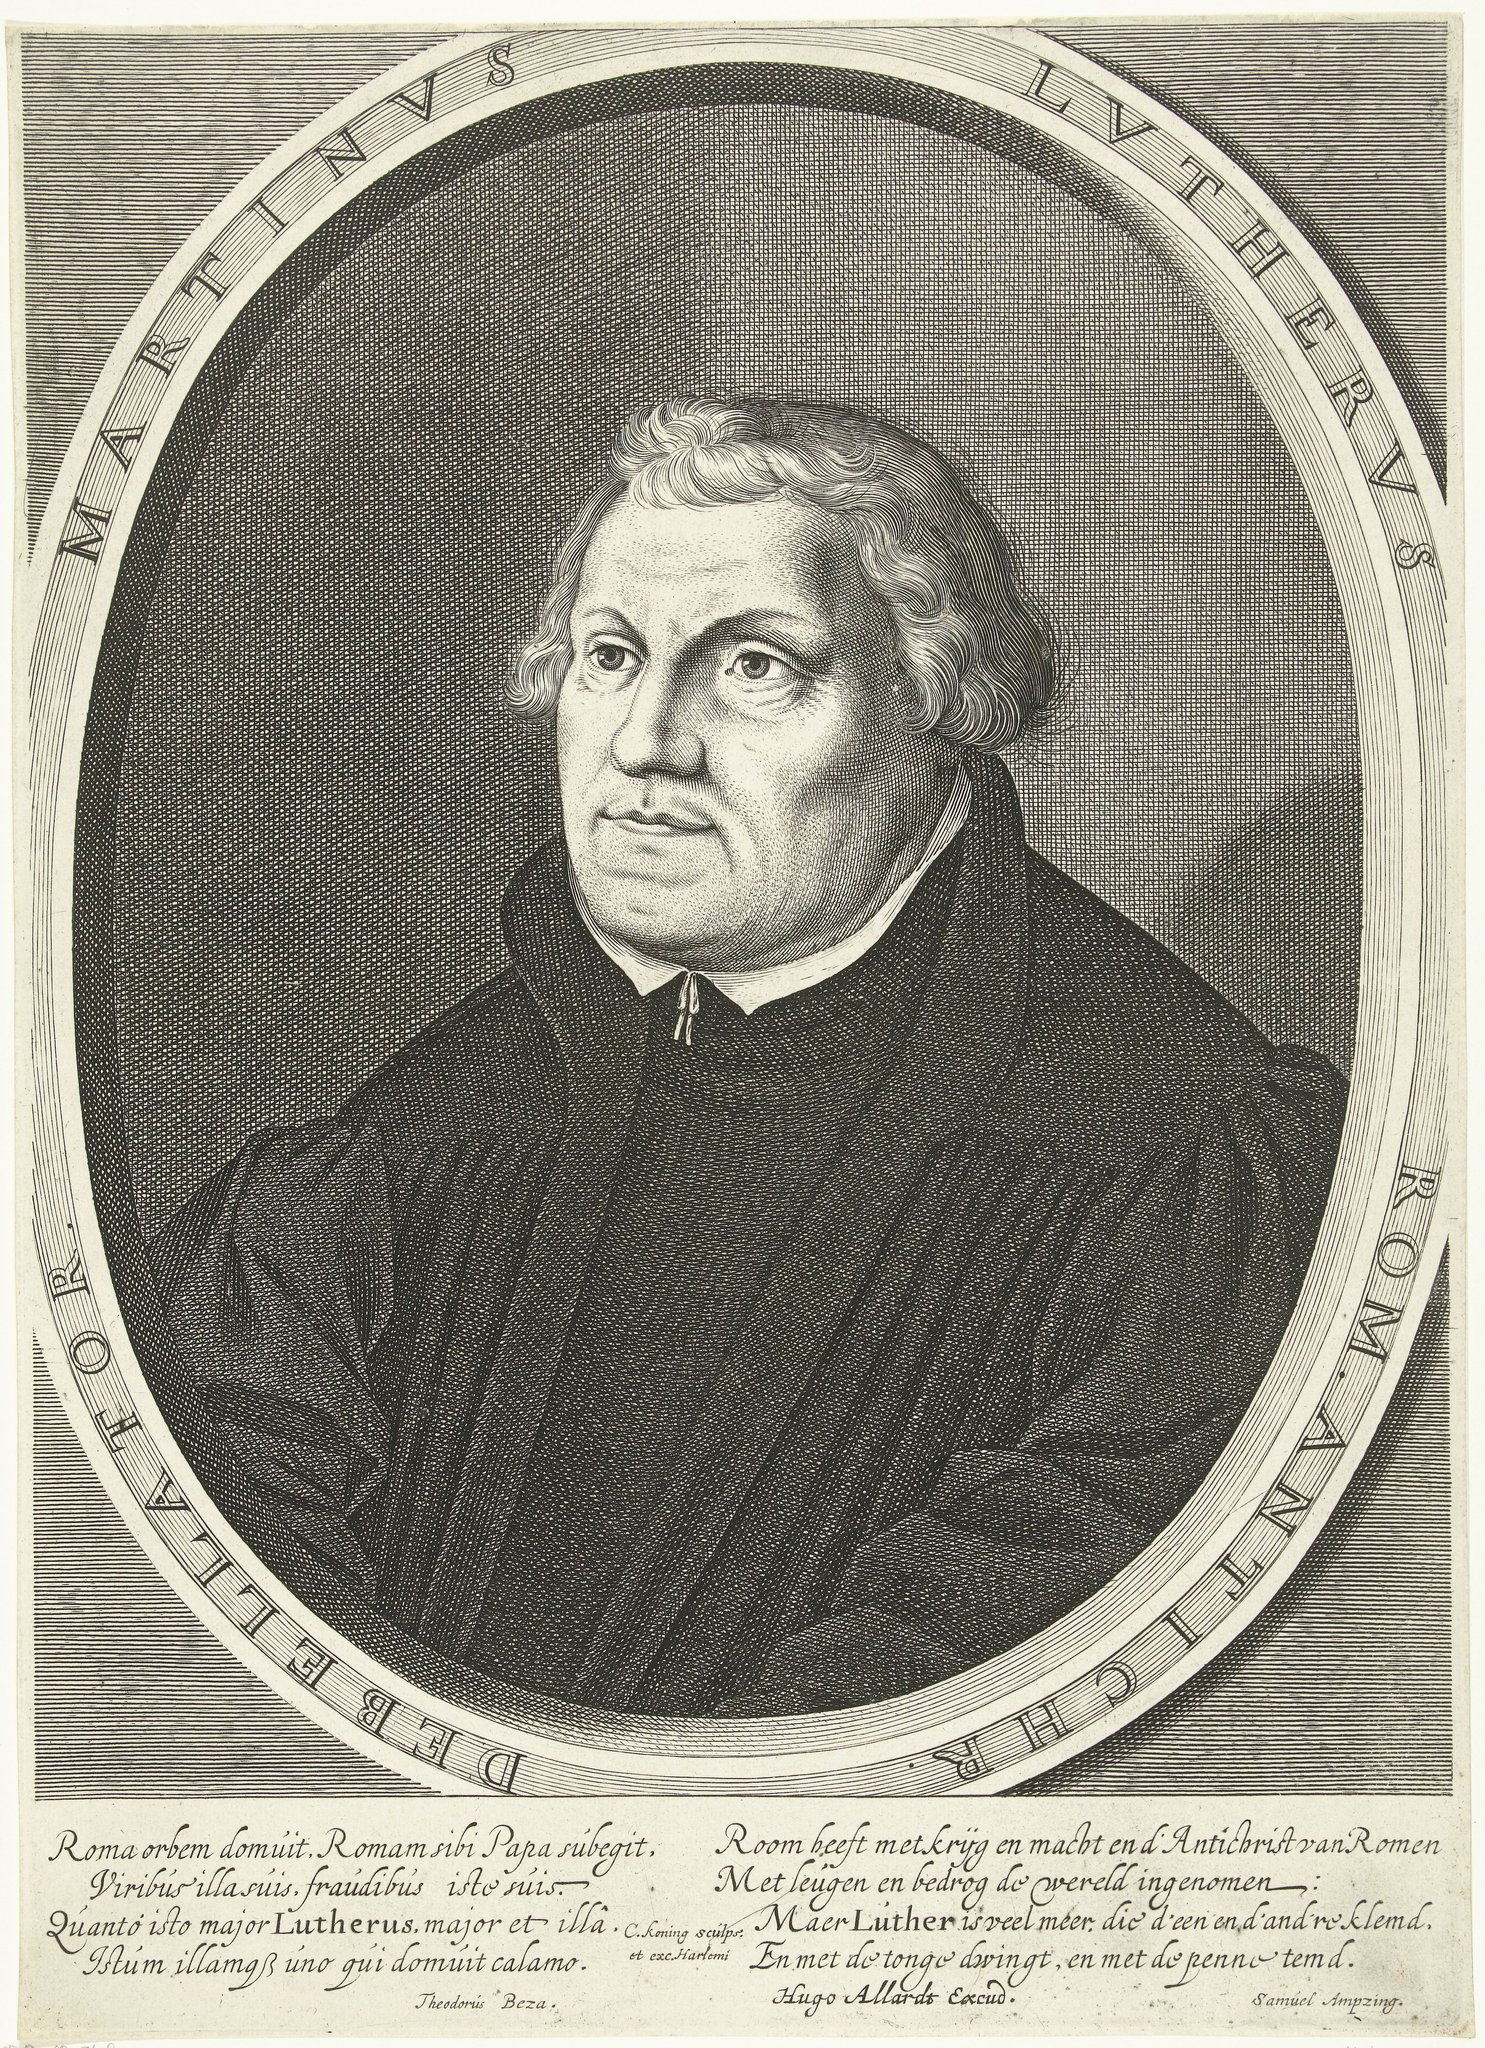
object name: print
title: Portret van Martin Luther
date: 1608-1671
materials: paper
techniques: engraving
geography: haarlem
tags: priest, martin luther, historical persons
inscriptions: collector's mark: Lugt 2228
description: Borstbeeld van de theoloog Martin Luther, in ovaal met randschrift. Onder het portret een vers in het Latijn en Nederlands.